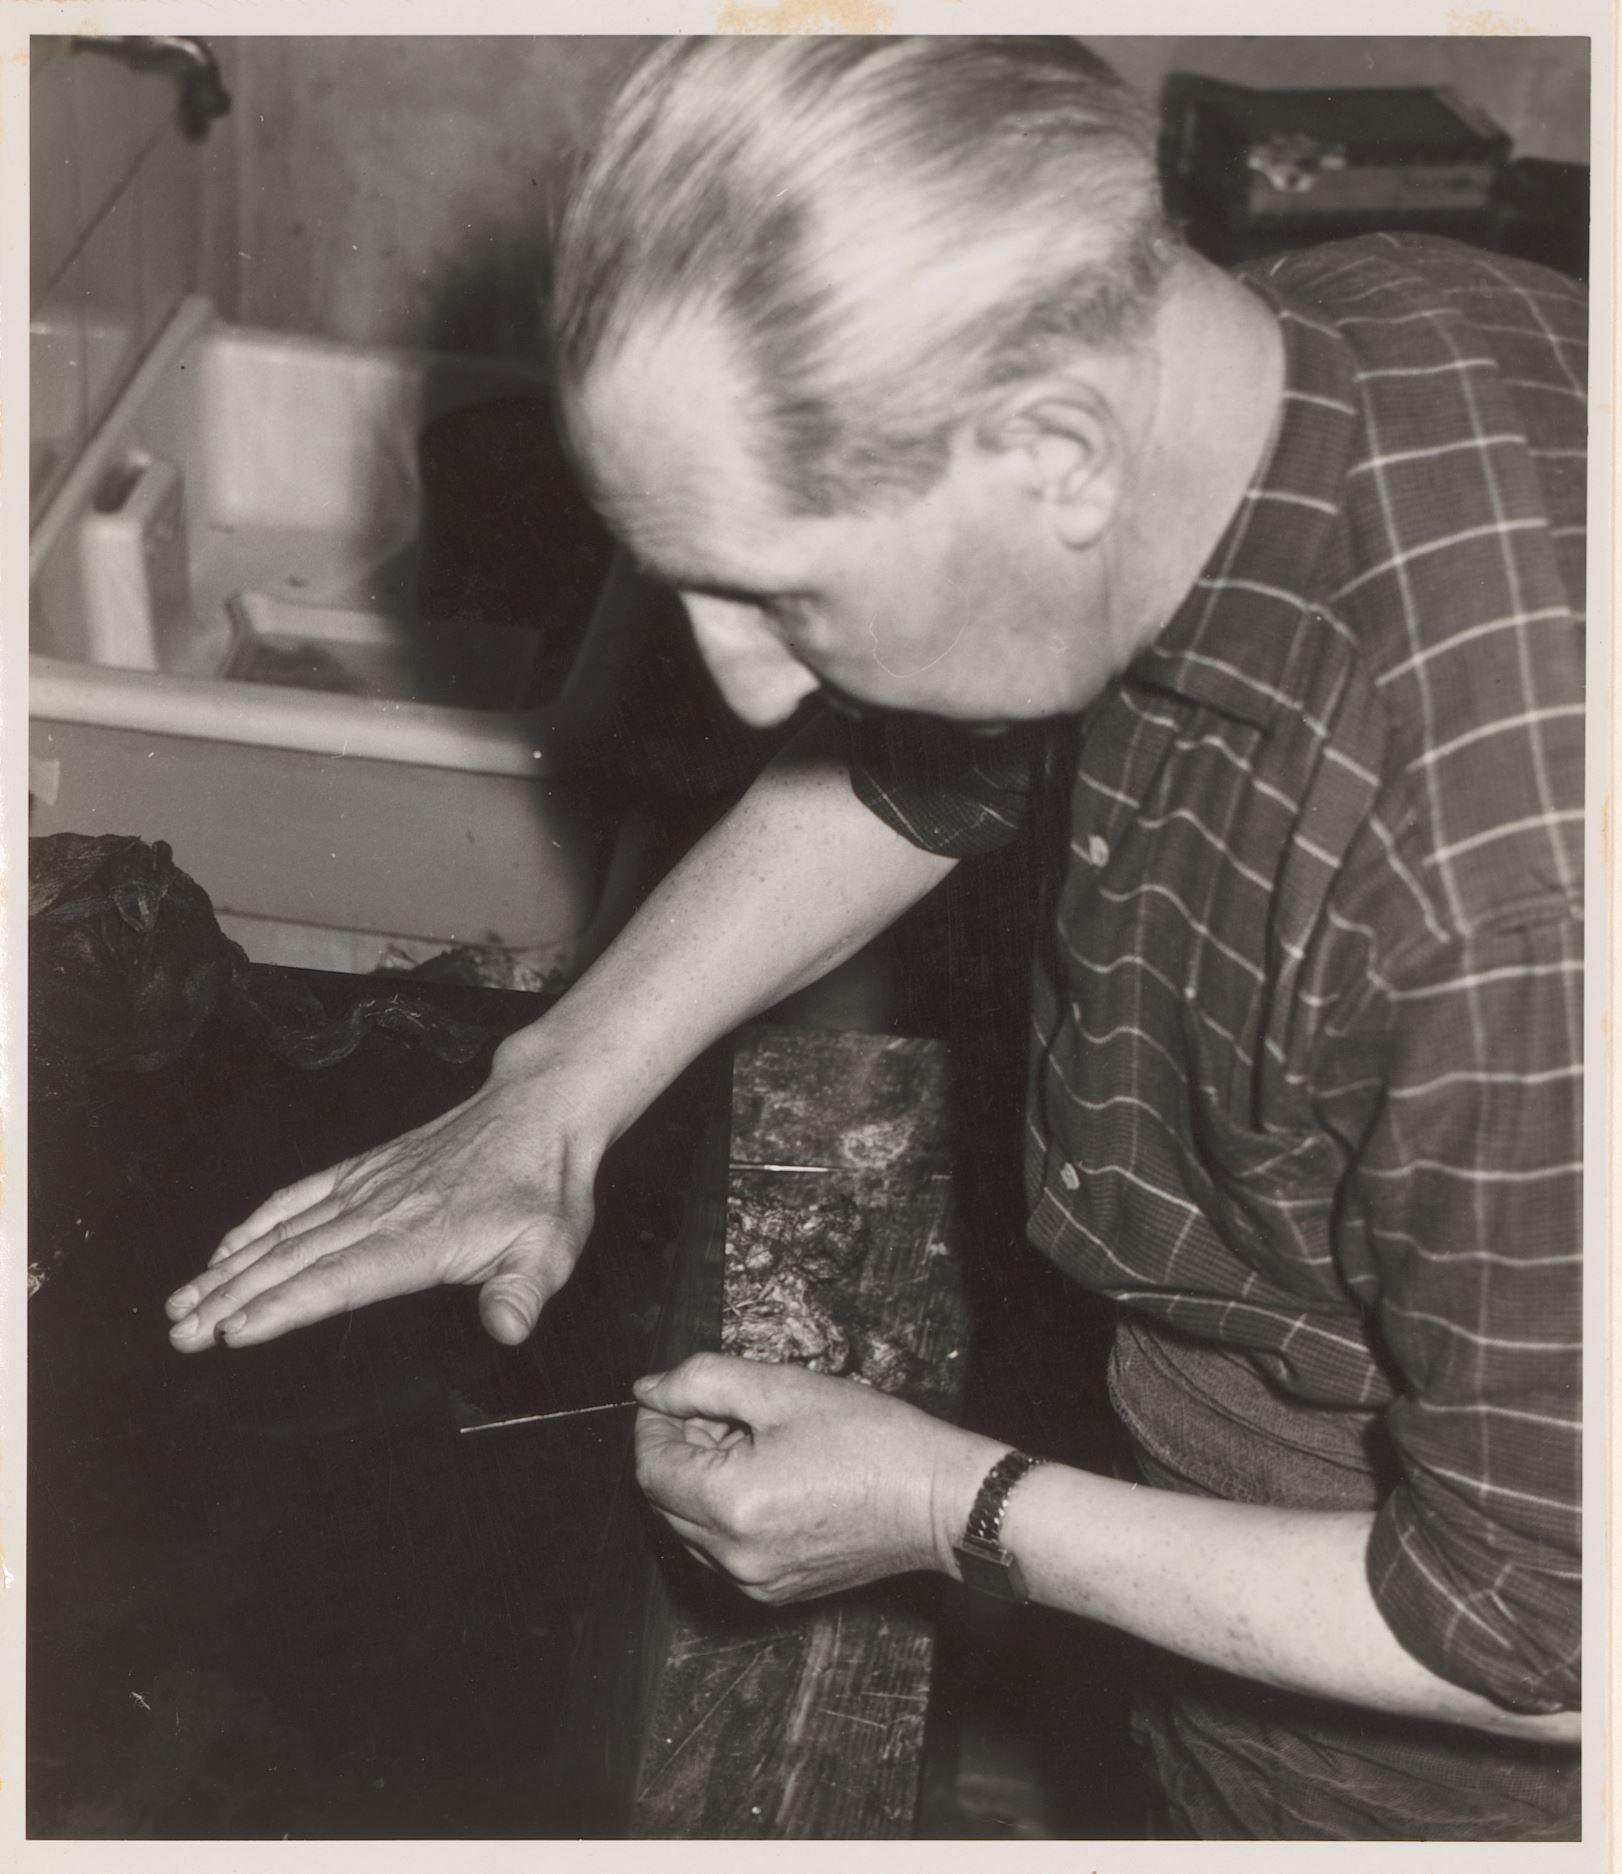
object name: photograph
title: Jan Poortenaar aan het werk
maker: Anonymous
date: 1930-1950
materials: paper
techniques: gelatin silver print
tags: amsterdam, print maker, jan poortenaar, engraver, etcher (+ artist at work)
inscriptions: collector's mark: Lugt 2228